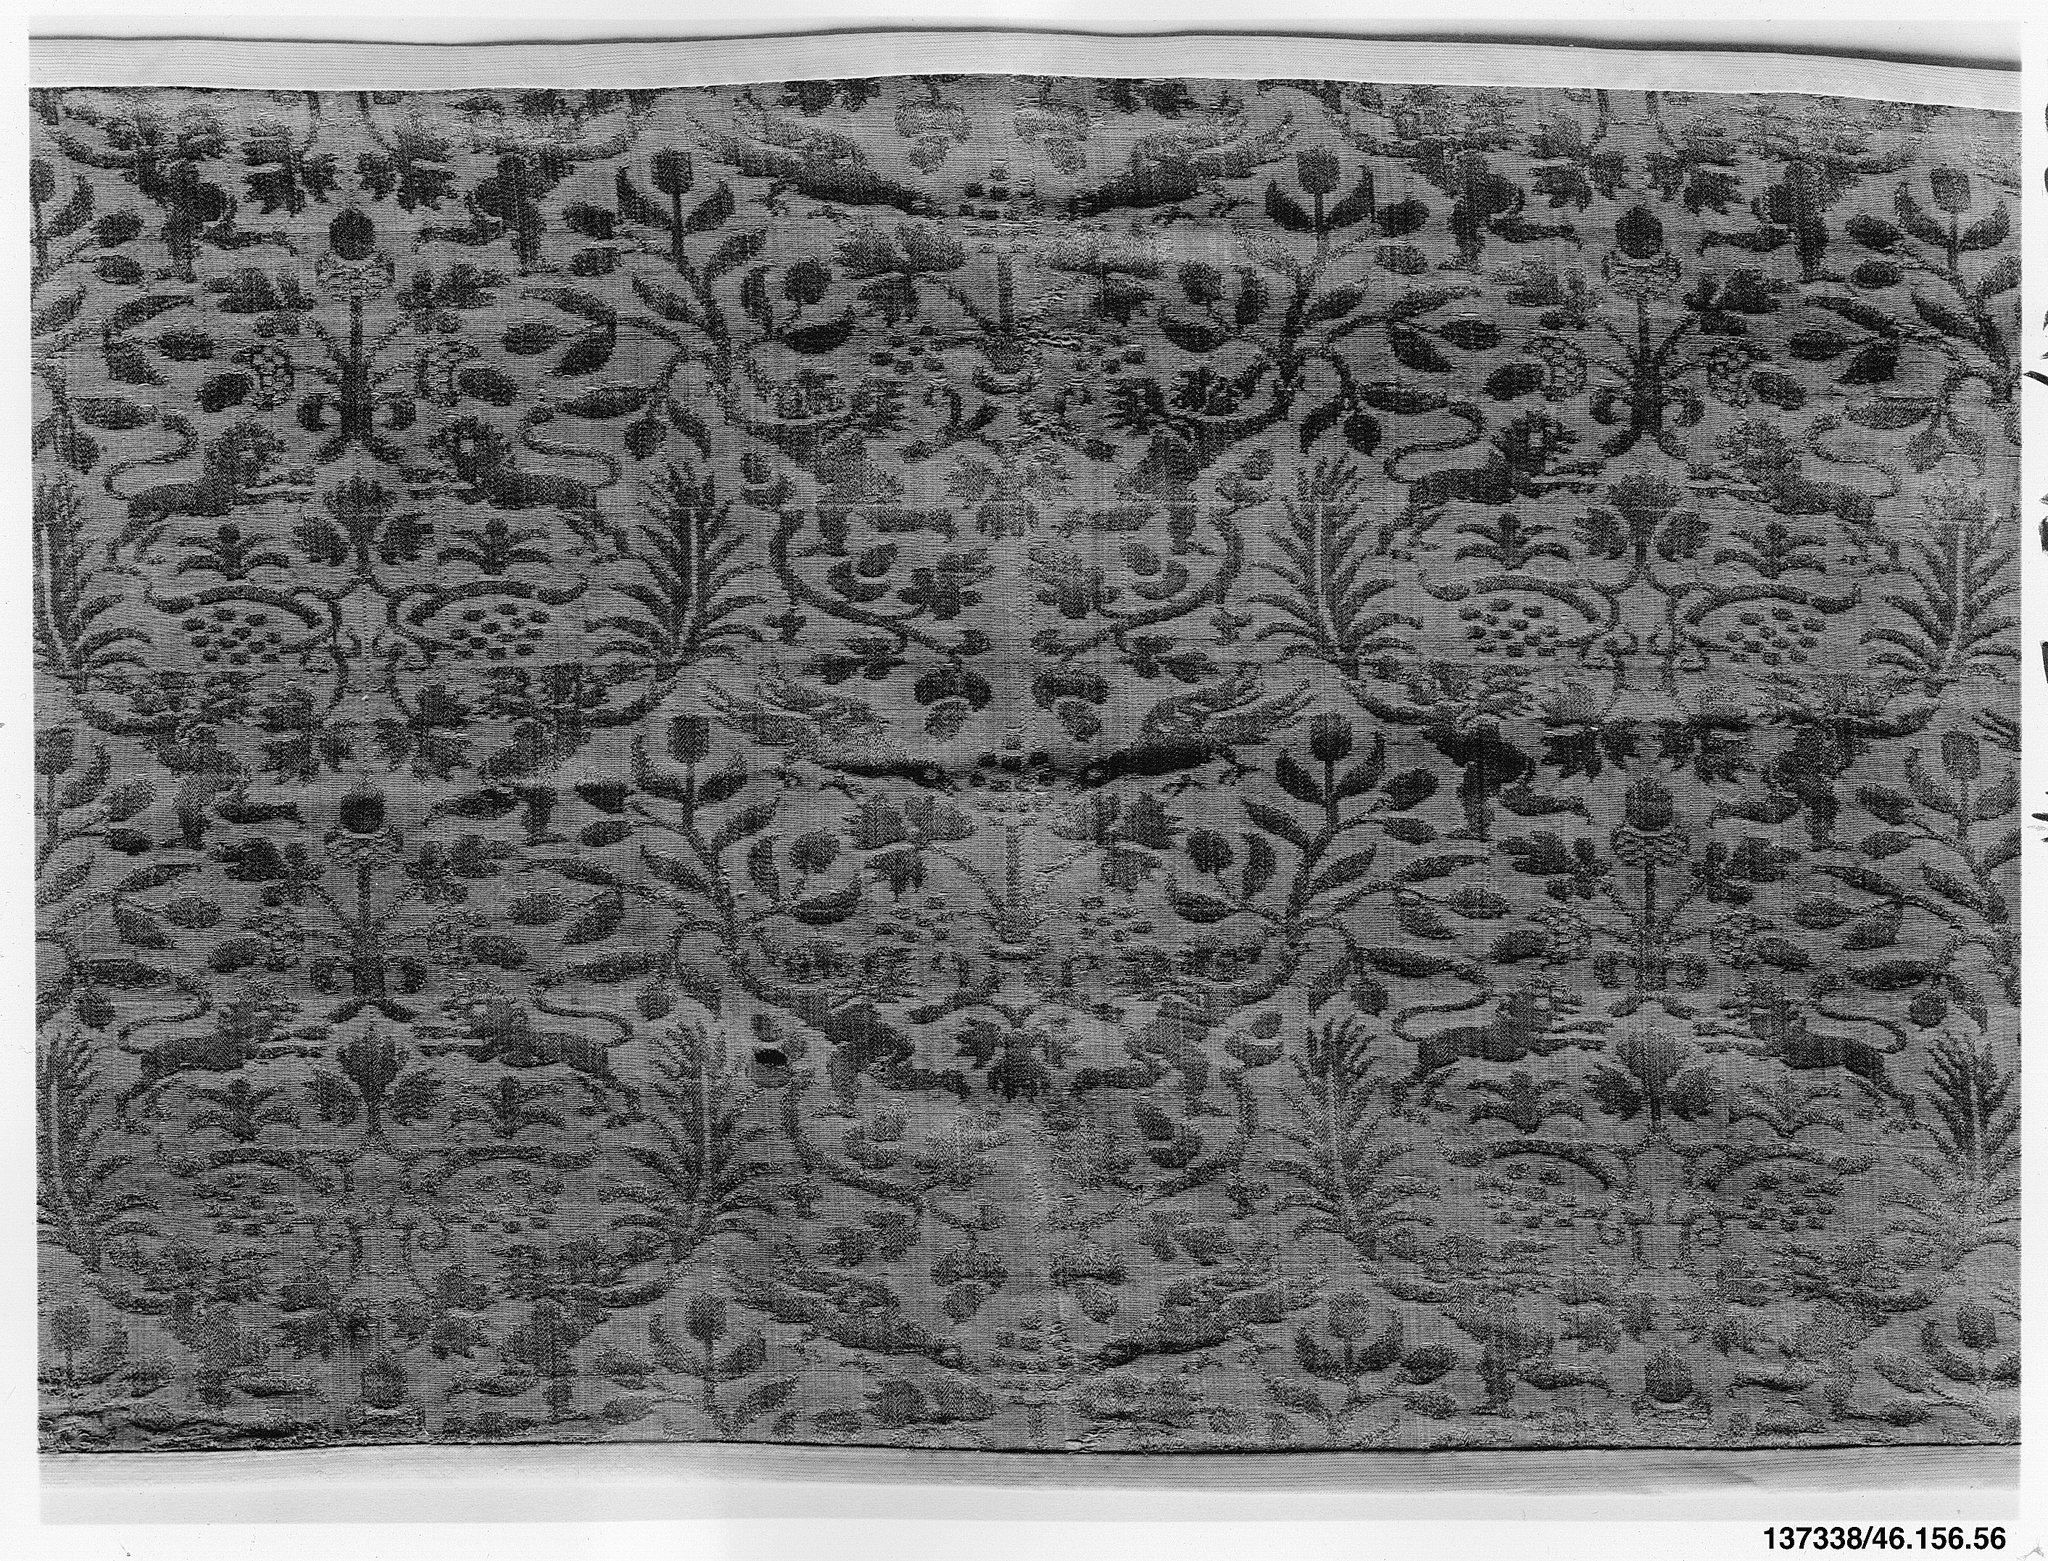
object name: panel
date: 1501-1600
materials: silk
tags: animals